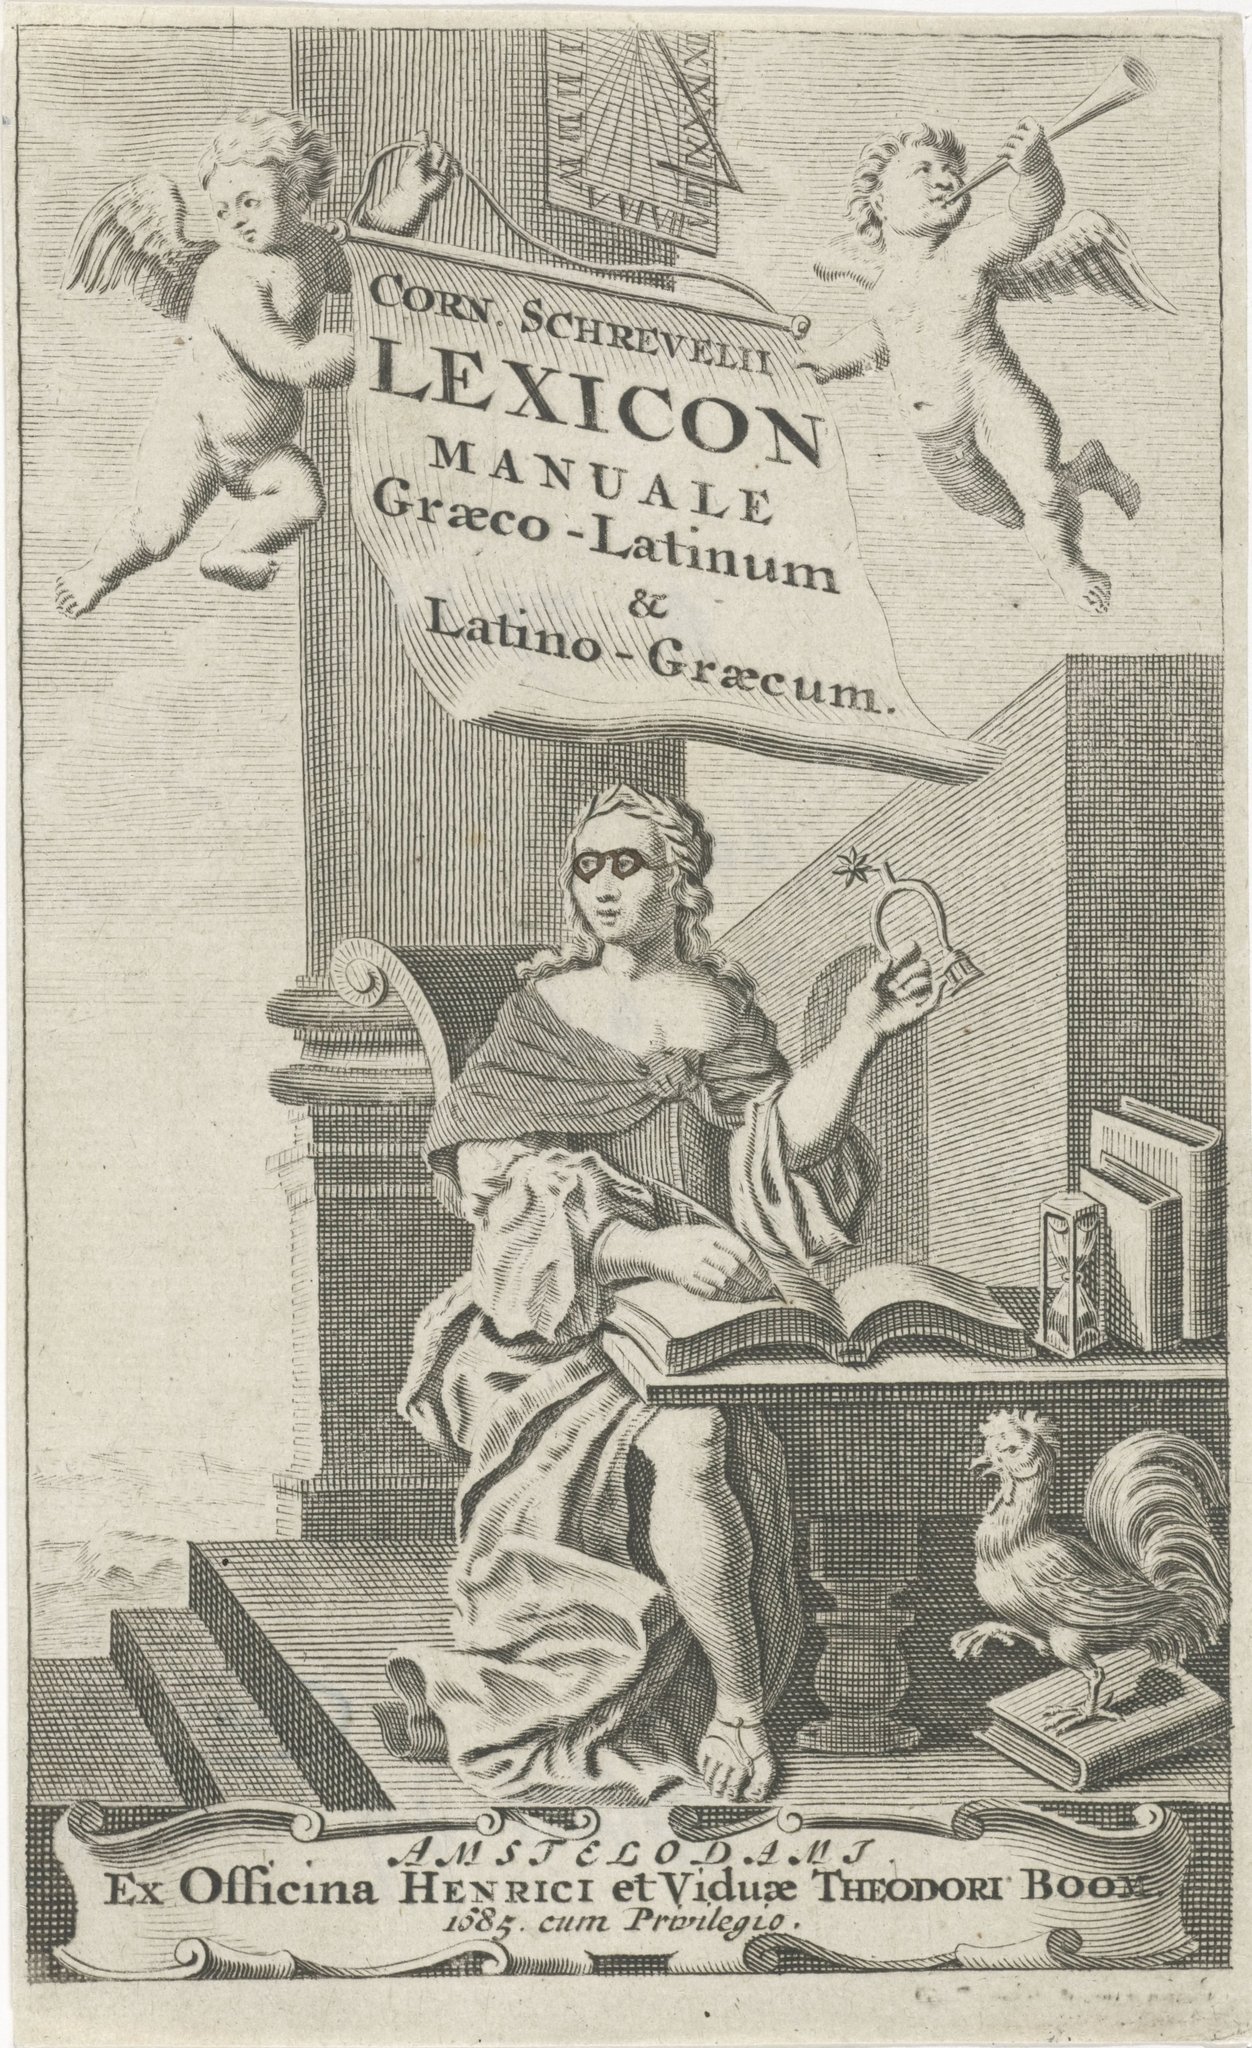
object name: print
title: Titelpagina voor: C. Schrevelius, Lexicon manuale Græco-Latinum & Latino-Græcum, 1685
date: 1685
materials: paper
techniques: engraving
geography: amsterdam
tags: hourglass, reason; 'ragione' (ripa), sundial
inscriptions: collector's mark: Lugt 2228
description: Een vrouw, in klassiek gewaad, zittend achter een schrijftafel, in de hand een spoor, als verwijzing naar de rede. Op de tafel een zandloper, als symbool voor vergankelijkheid Aan haar voeten een haan, als symbool voor waakzaamheid. Op de zuil achter haar een zonnewijzer, die verwijst naar het verstrijken van de tijd. Twee engelen houden een banier vast waarop de titel in het Latijn. Onderaan in een cartouche een impressum in het Latijn.